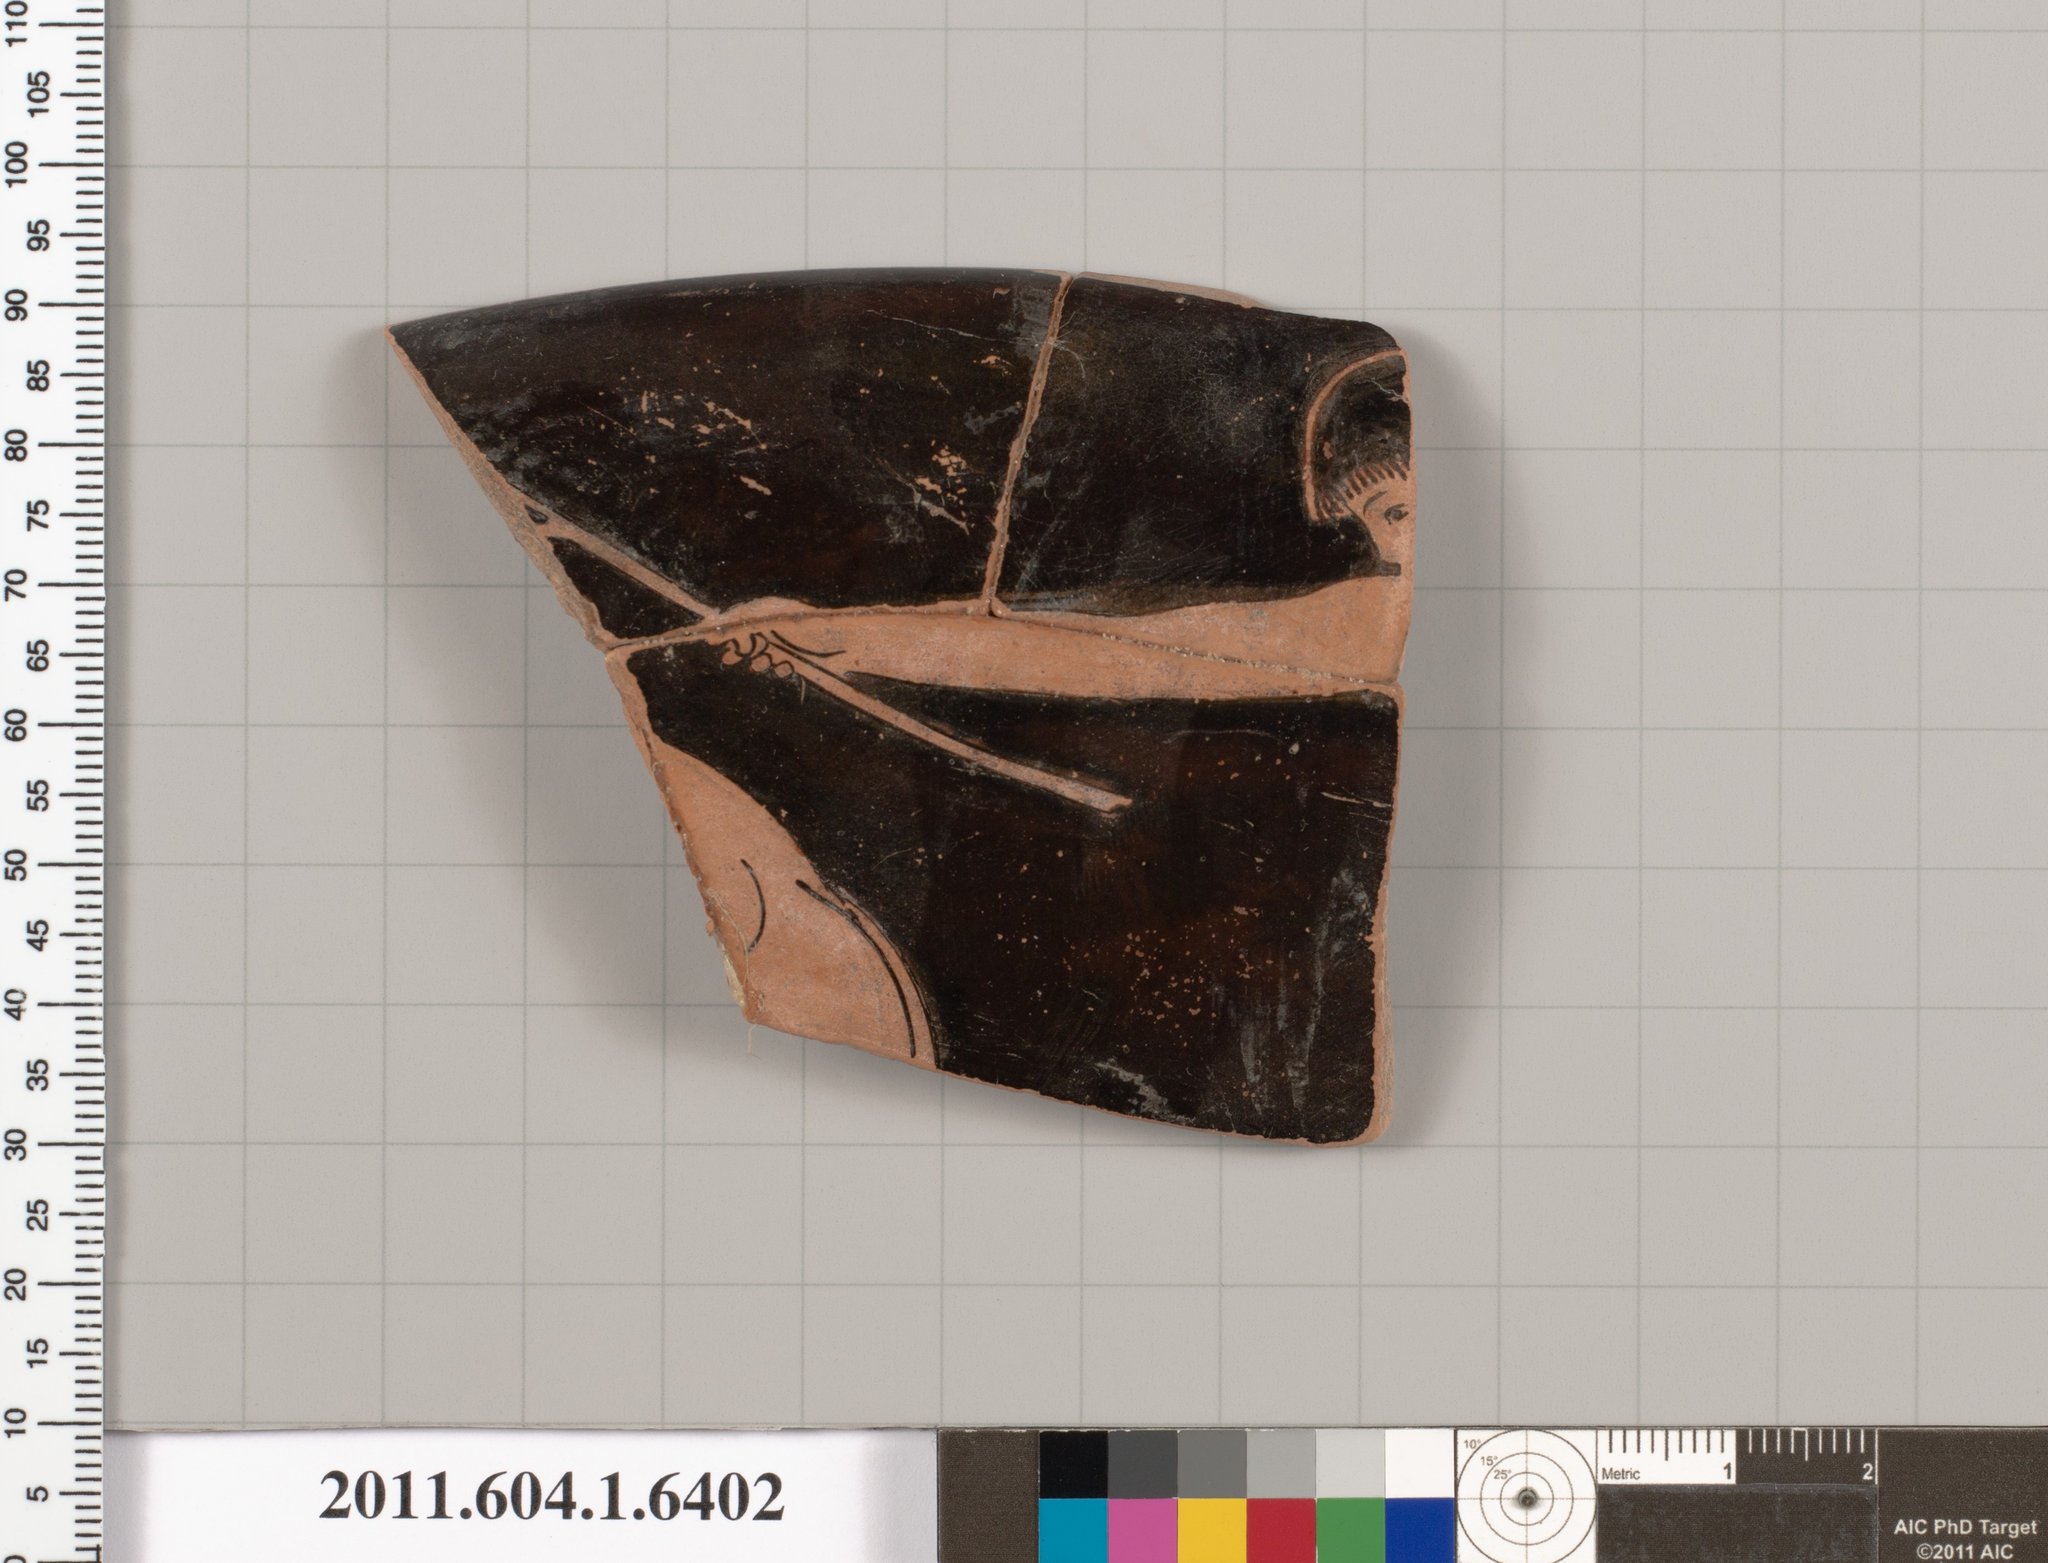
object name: kylix fragment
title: Terracotta rim fragment of a kylix (drinking cup)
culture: greek, attic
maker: antiphon painter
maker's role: artist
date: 490-480 BCE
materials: terracotta